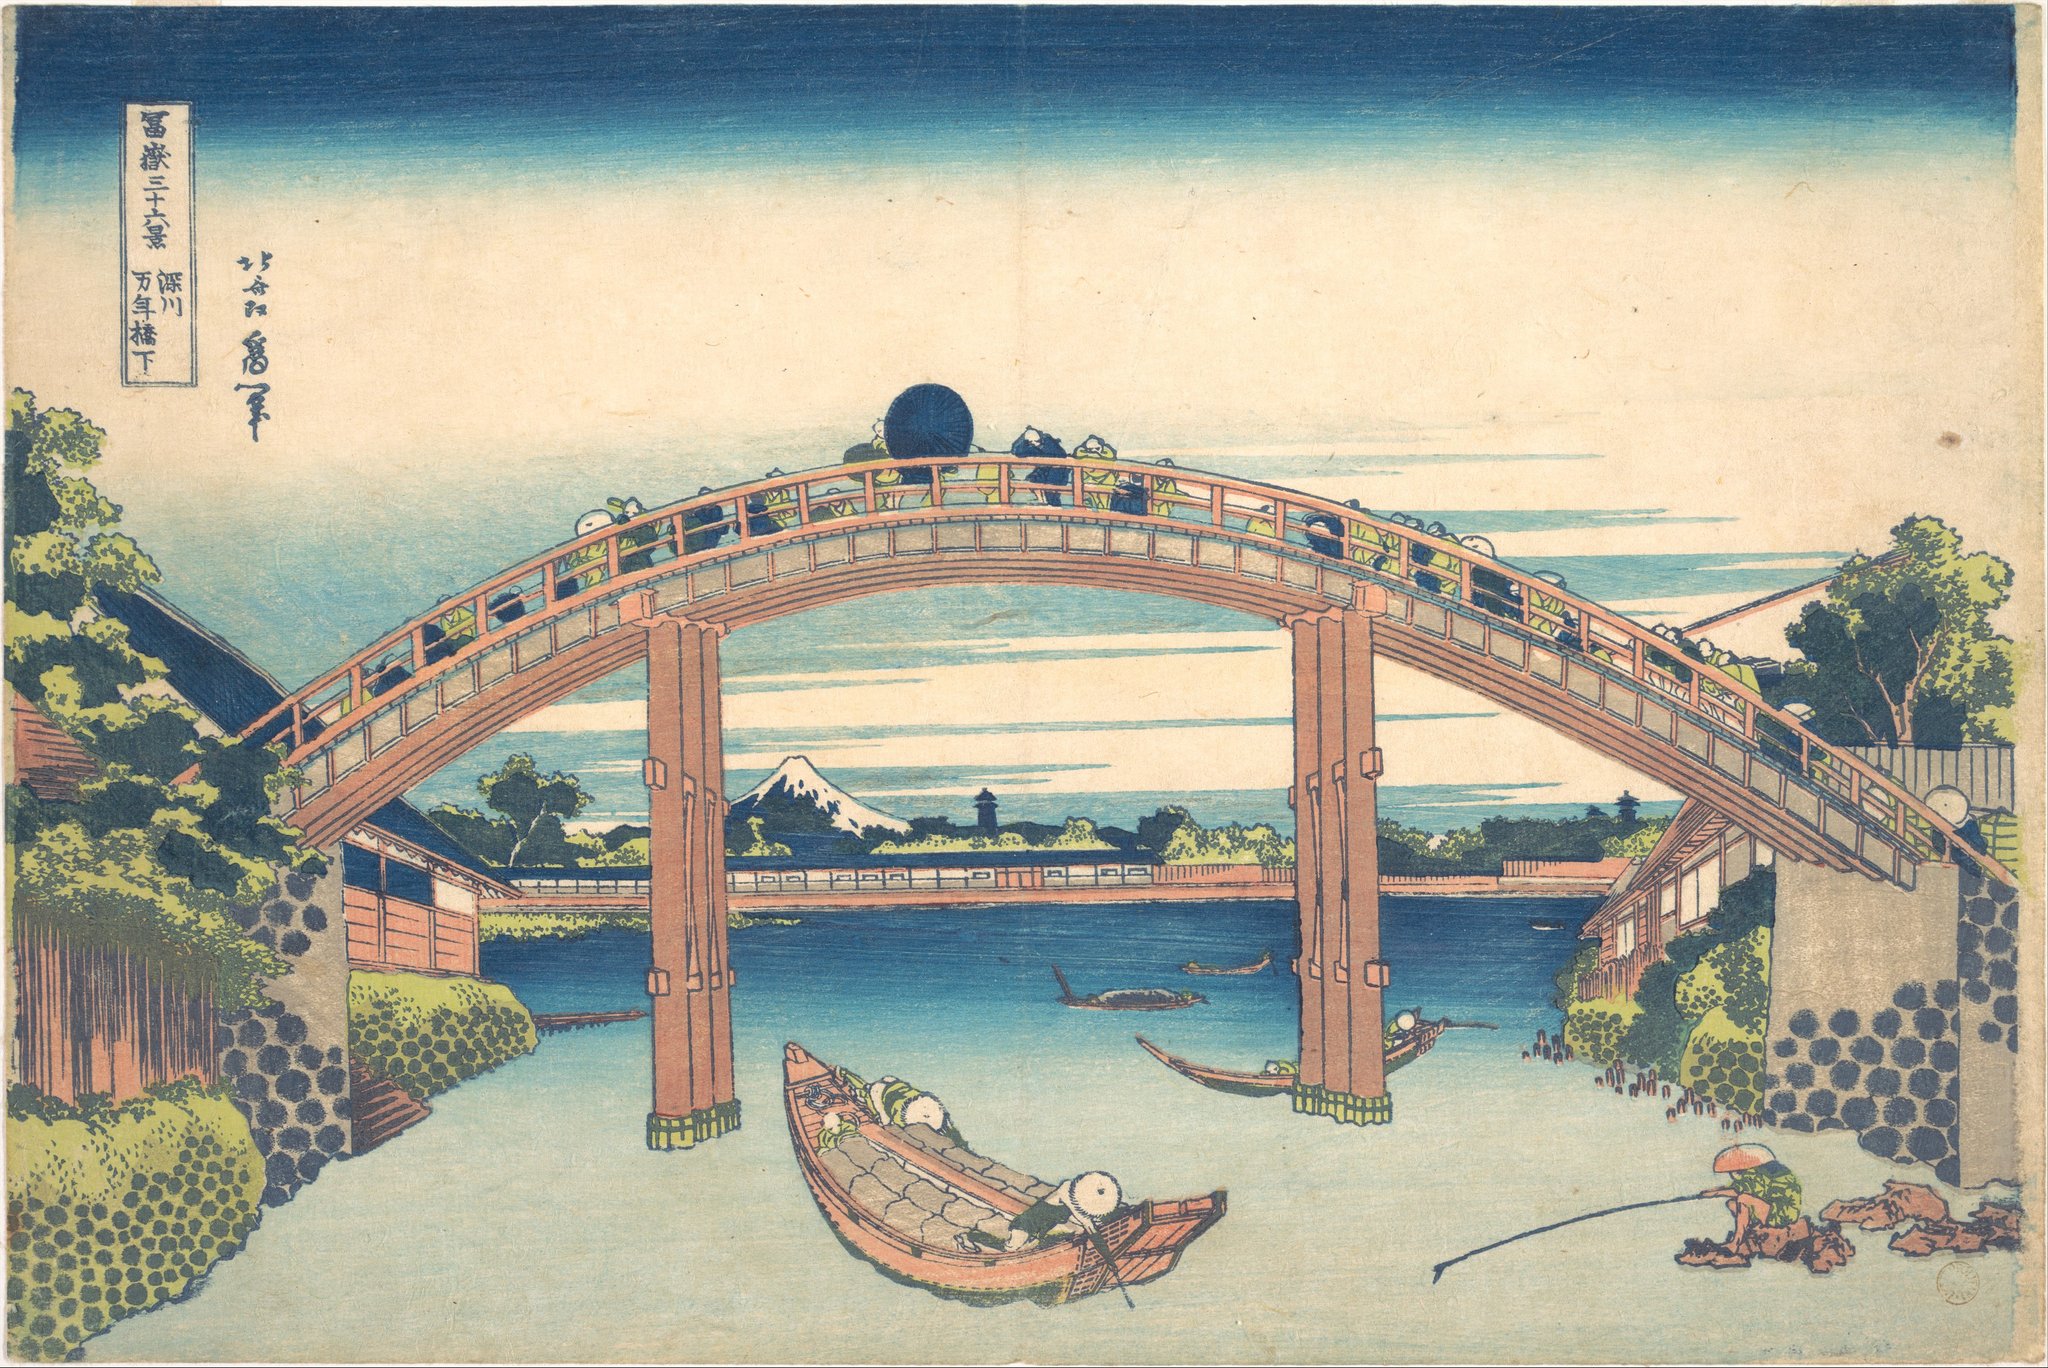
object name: woodblock print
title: Under the Mannen Bridge at Fukagawa (Fukagawa Mannenbashi shita), from the series Thirty-six Views of Mount Fuji (Fugaku sanjūrokkei)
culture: japanese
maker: katsushika hokusai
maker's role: artist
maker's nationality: japanese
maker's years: 1760-1849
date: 1830-1832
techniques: woodblock print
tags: bridges,rivers,boats